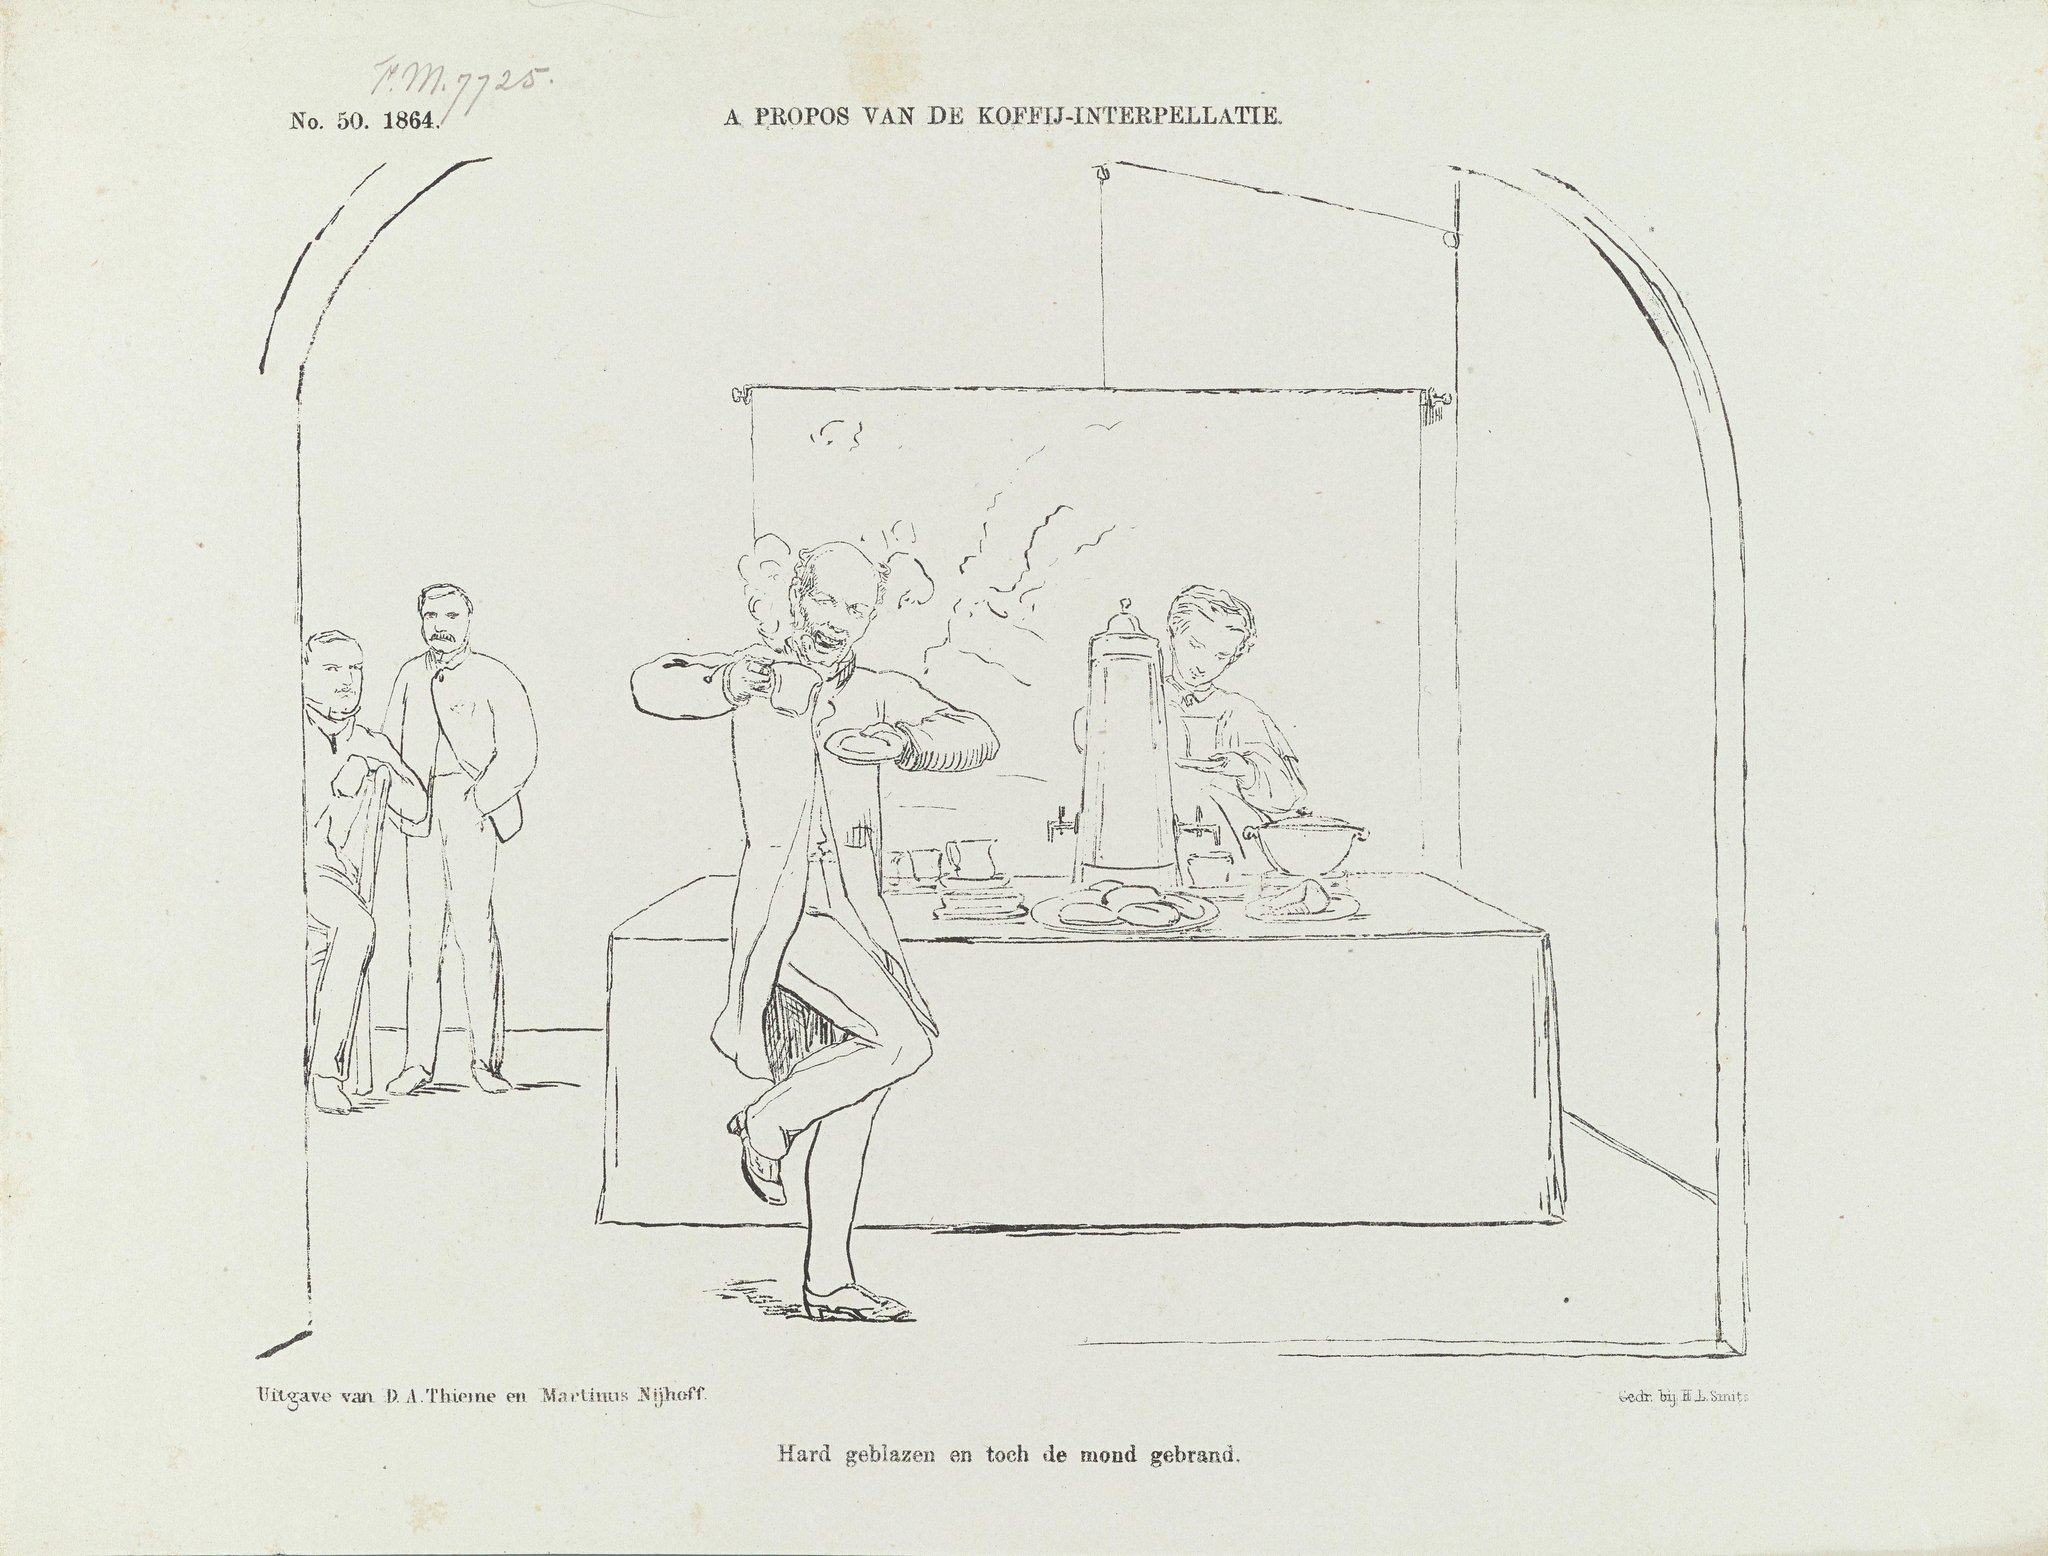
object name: cartoon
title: A propos van de koffij-interpellatie / Hard geblazen en toch de mond gebrand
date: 1864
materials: paper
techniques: lithograph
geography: netherlands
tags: cup of coffee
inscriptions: collector's mark: Lugt 2228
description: Spotprent op de interpellatie van Rochussen over het omhakken van koffiebomen in Indië. J.J. Rochussen brandt zijn mond bij het drinken van hete koffie in de koffiekamer van de Tweede Kamer, I.D. Fransen van de Putte en C. van Heukelom kijken toe. Plaat verschenen bij het weekblad De Nederlandsche Spectator, nr. 50, 10 december 1864.